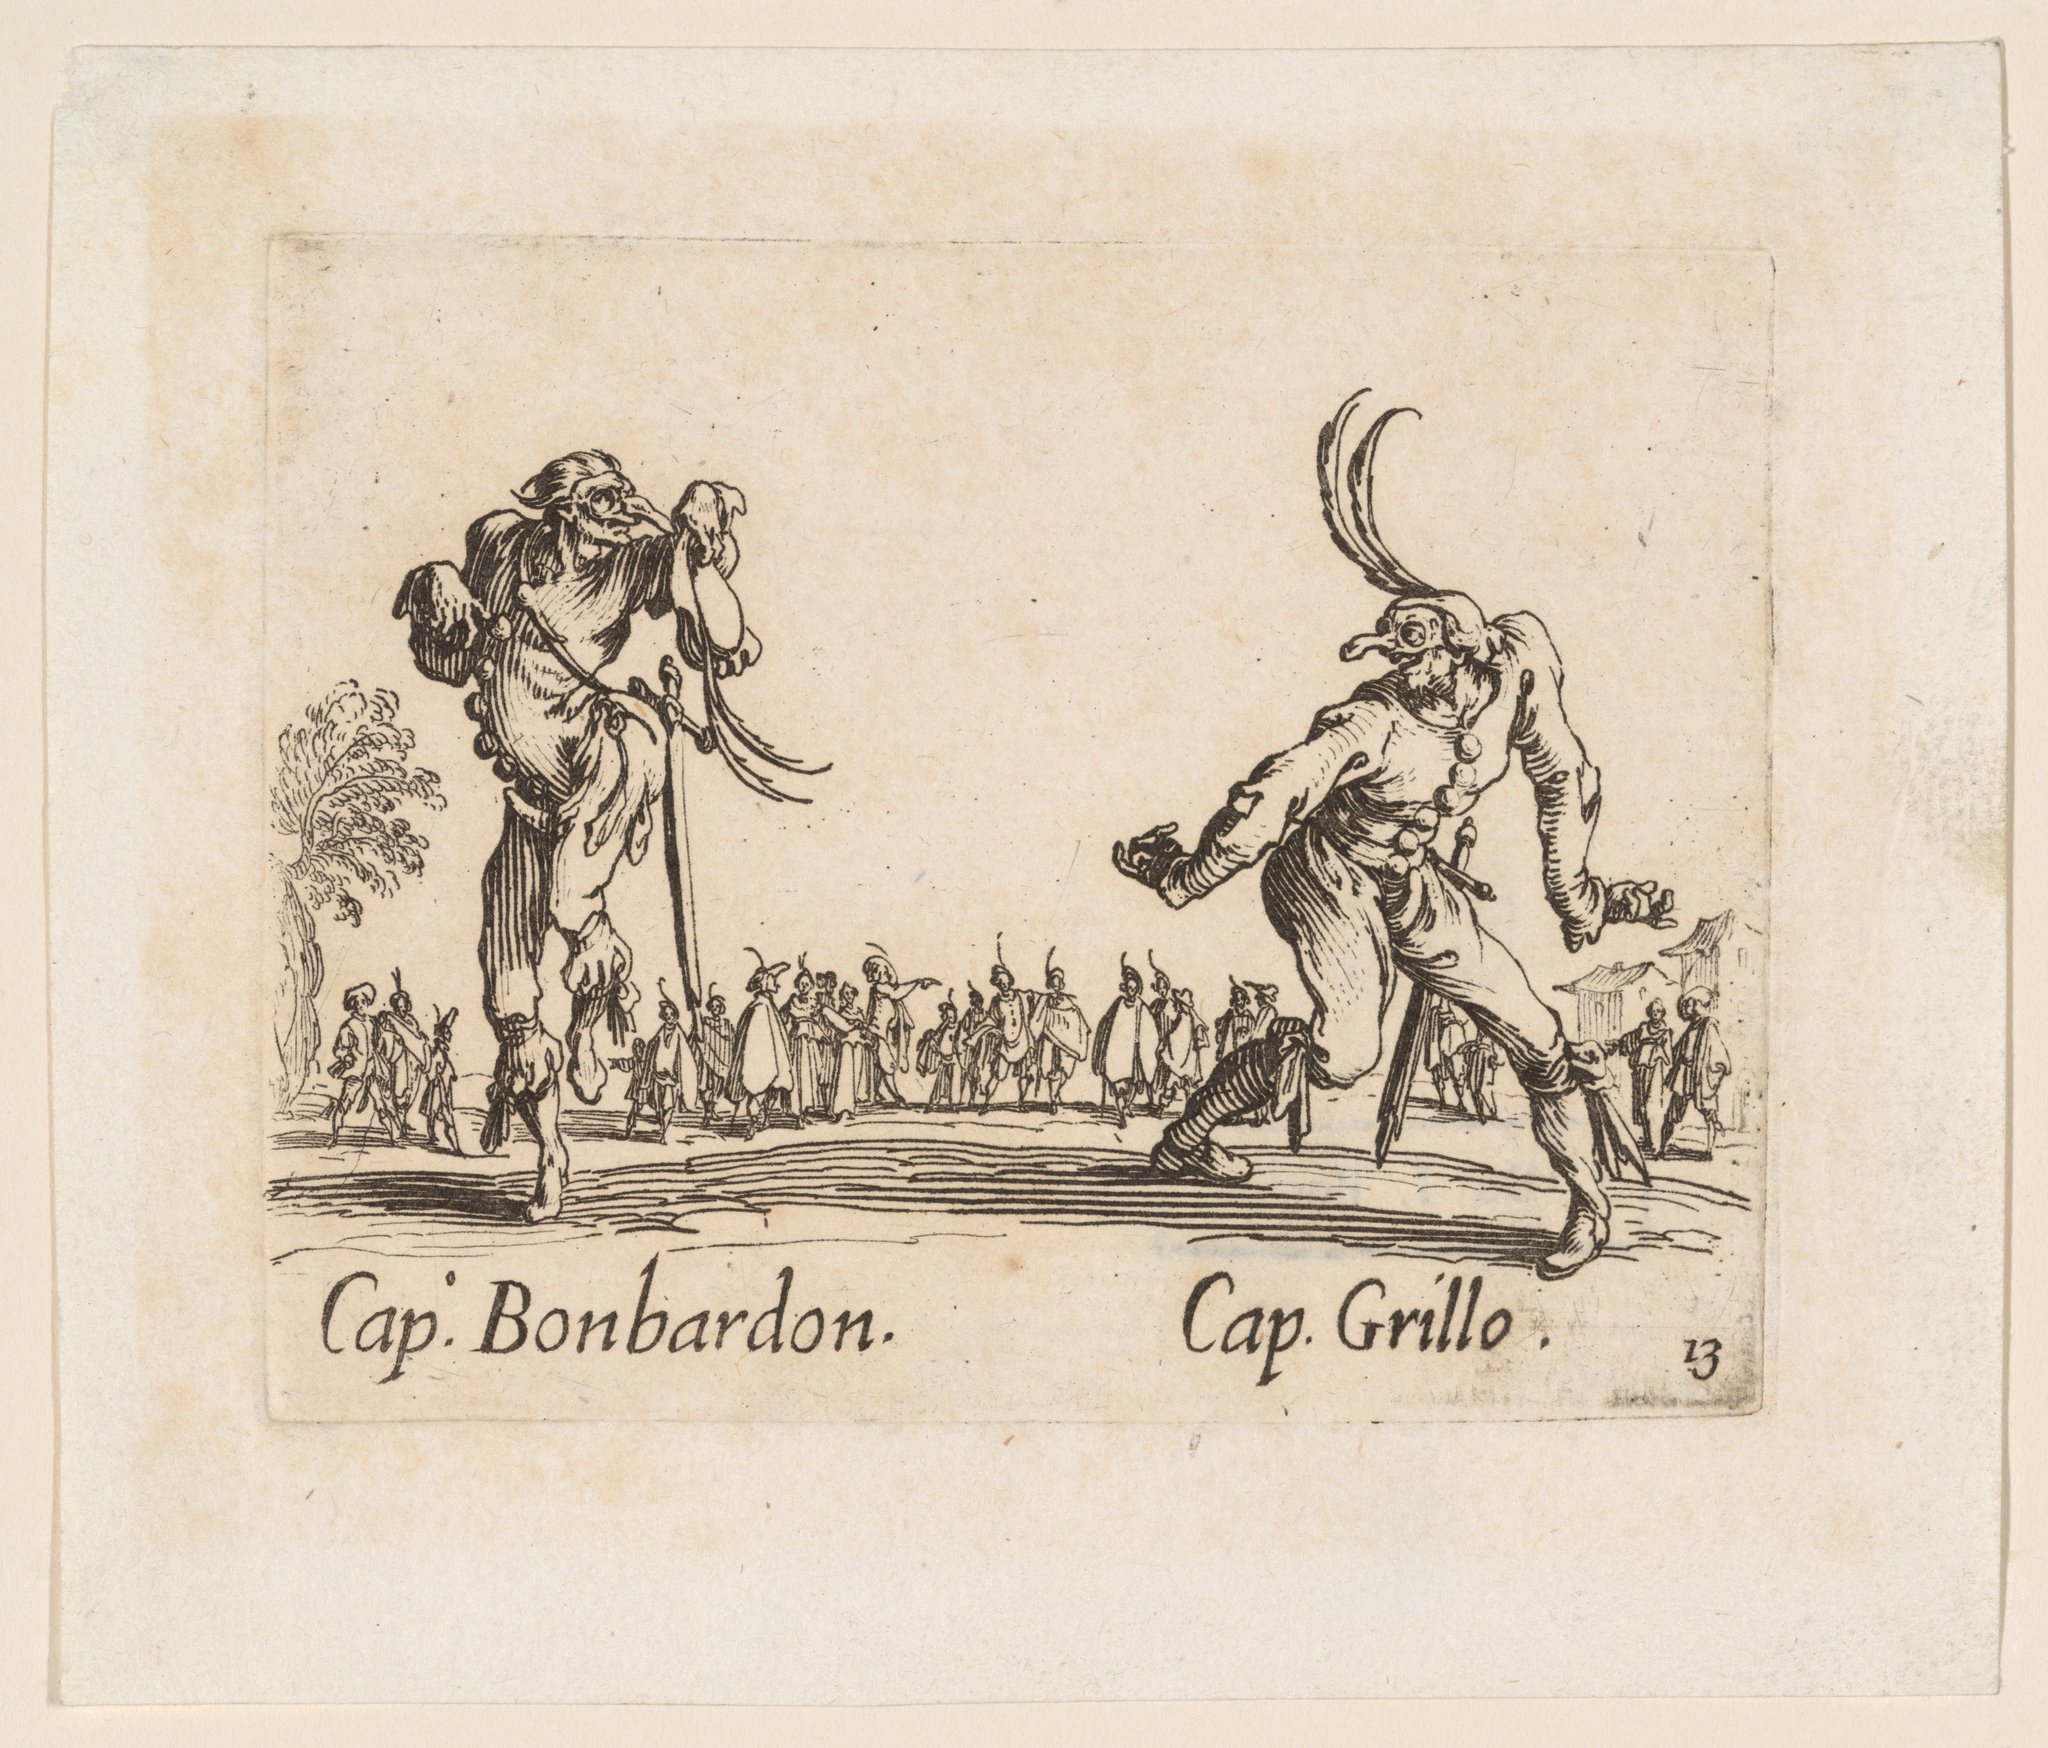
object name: print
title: Capitano Bonbardon and Capitano Grillo, plate 13 from "Balli di Sfessania" (Dance of Sfessania)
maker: jacques callot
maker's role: artist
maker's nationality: french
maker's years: 1592-1635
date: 1621-1622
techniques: etching